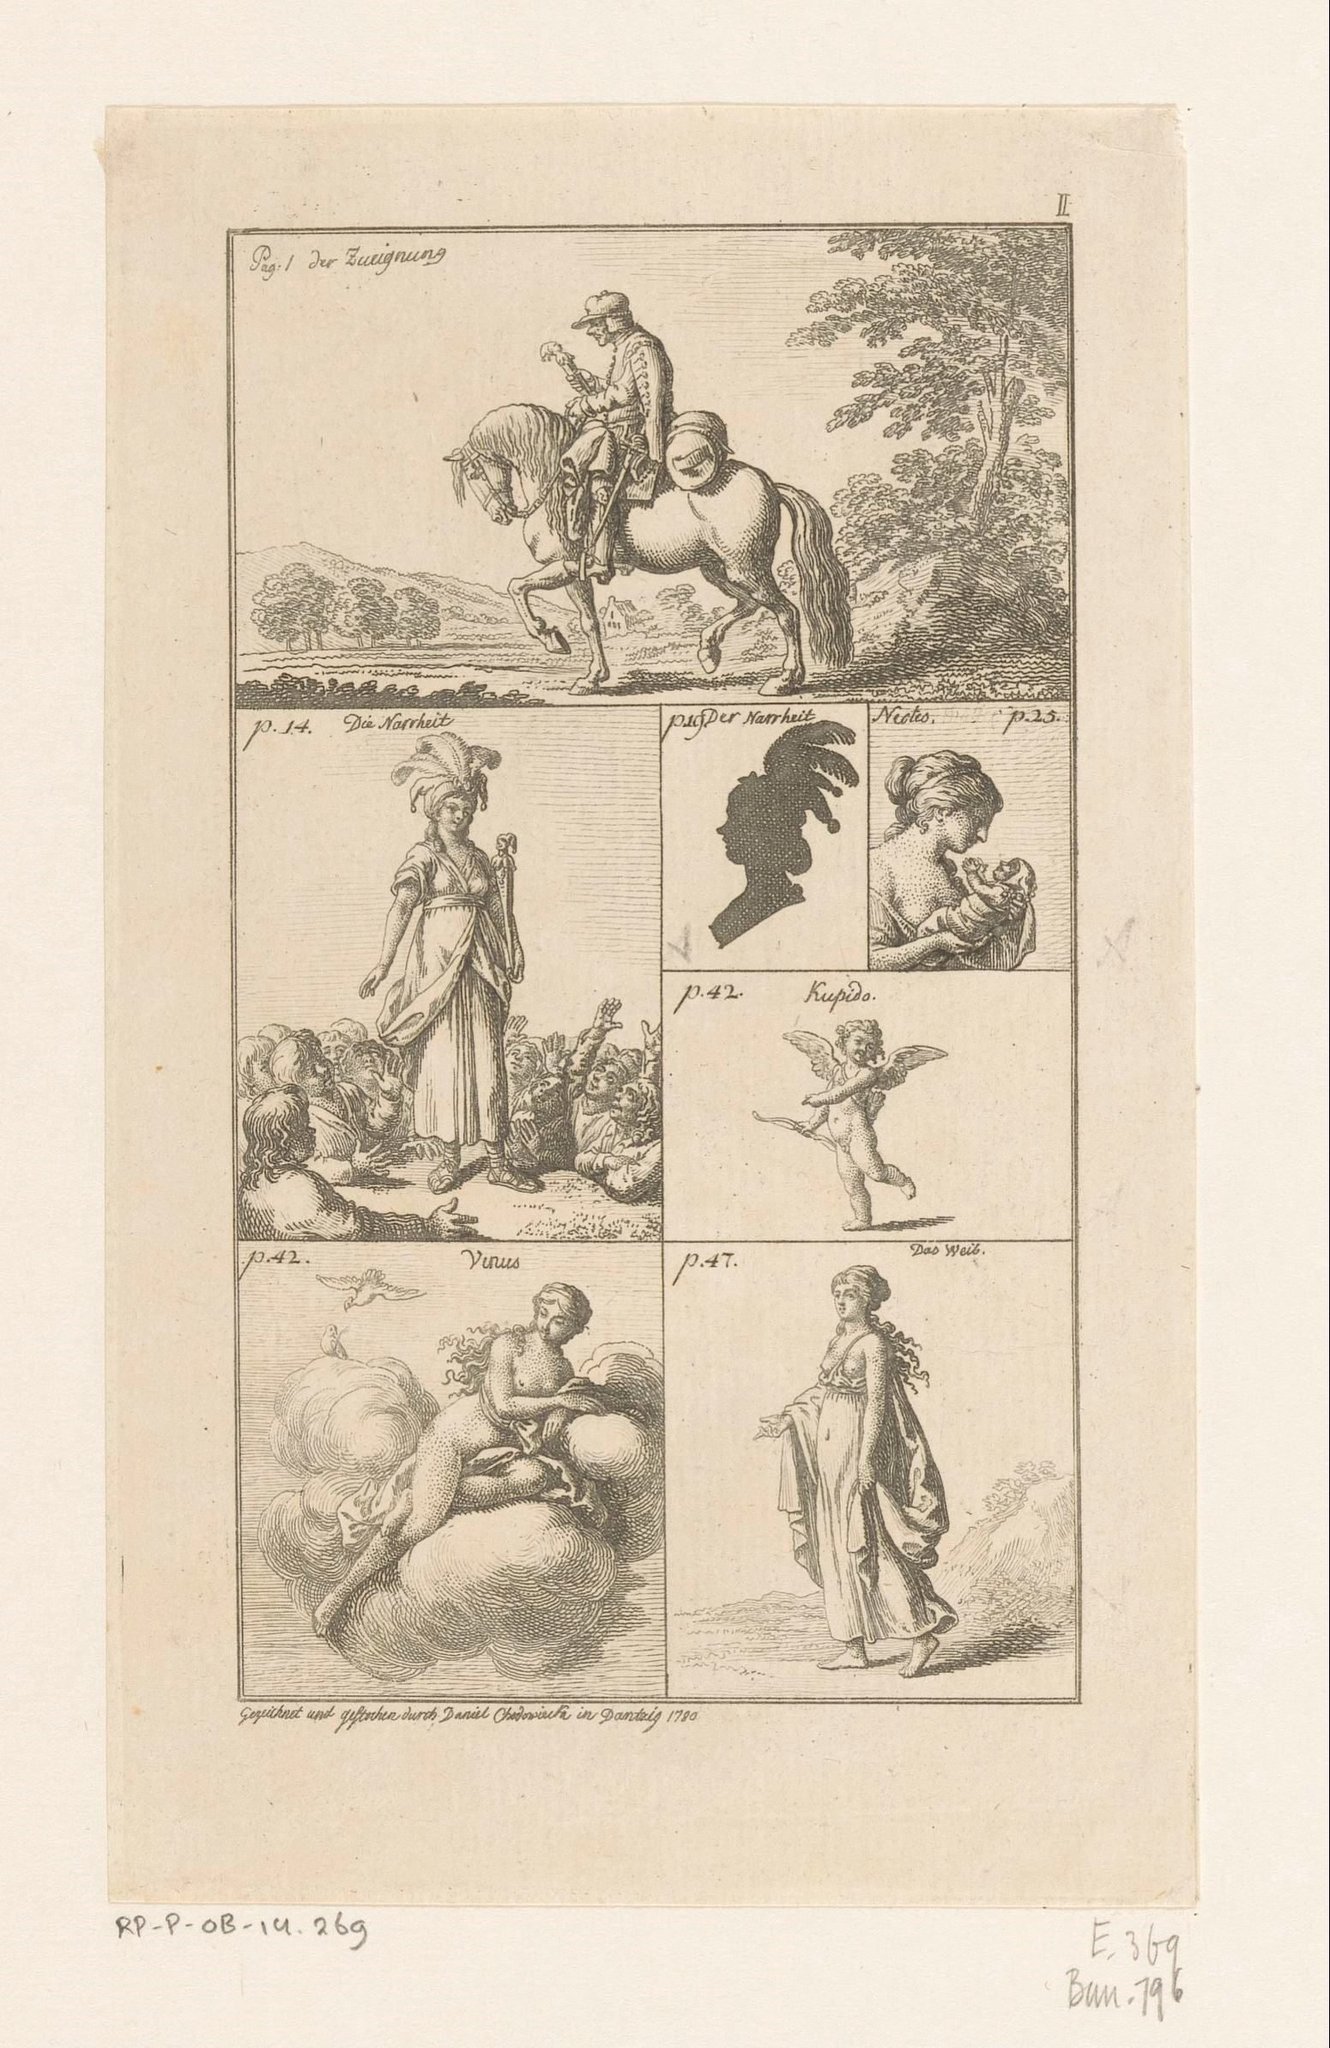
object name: print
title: Blad uit De Lof der Zotheid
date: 1780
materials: paper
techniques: etching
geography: gdansk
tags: rotterdam, desiderius erasmus, riding a horse, ass, or mule; rider, horseman, female sex; woman, folly, foolishness; 'pazzia', 'sciocchezza', 'stoltitia' (ripa), fool's cap, cupids: 'amores', 'amoretti', 'putti', other specific aspects of venus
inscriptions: collector's mark: Lugt 2228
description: Blad met zeven omkaderde illustraties, elk behorend tot een apart tekstdeel. Afgebeeld zijn: de toewijding, de zotheid, Neotis, Cupido, Venus en de vrouw. Rechtsboven genummerd: I.